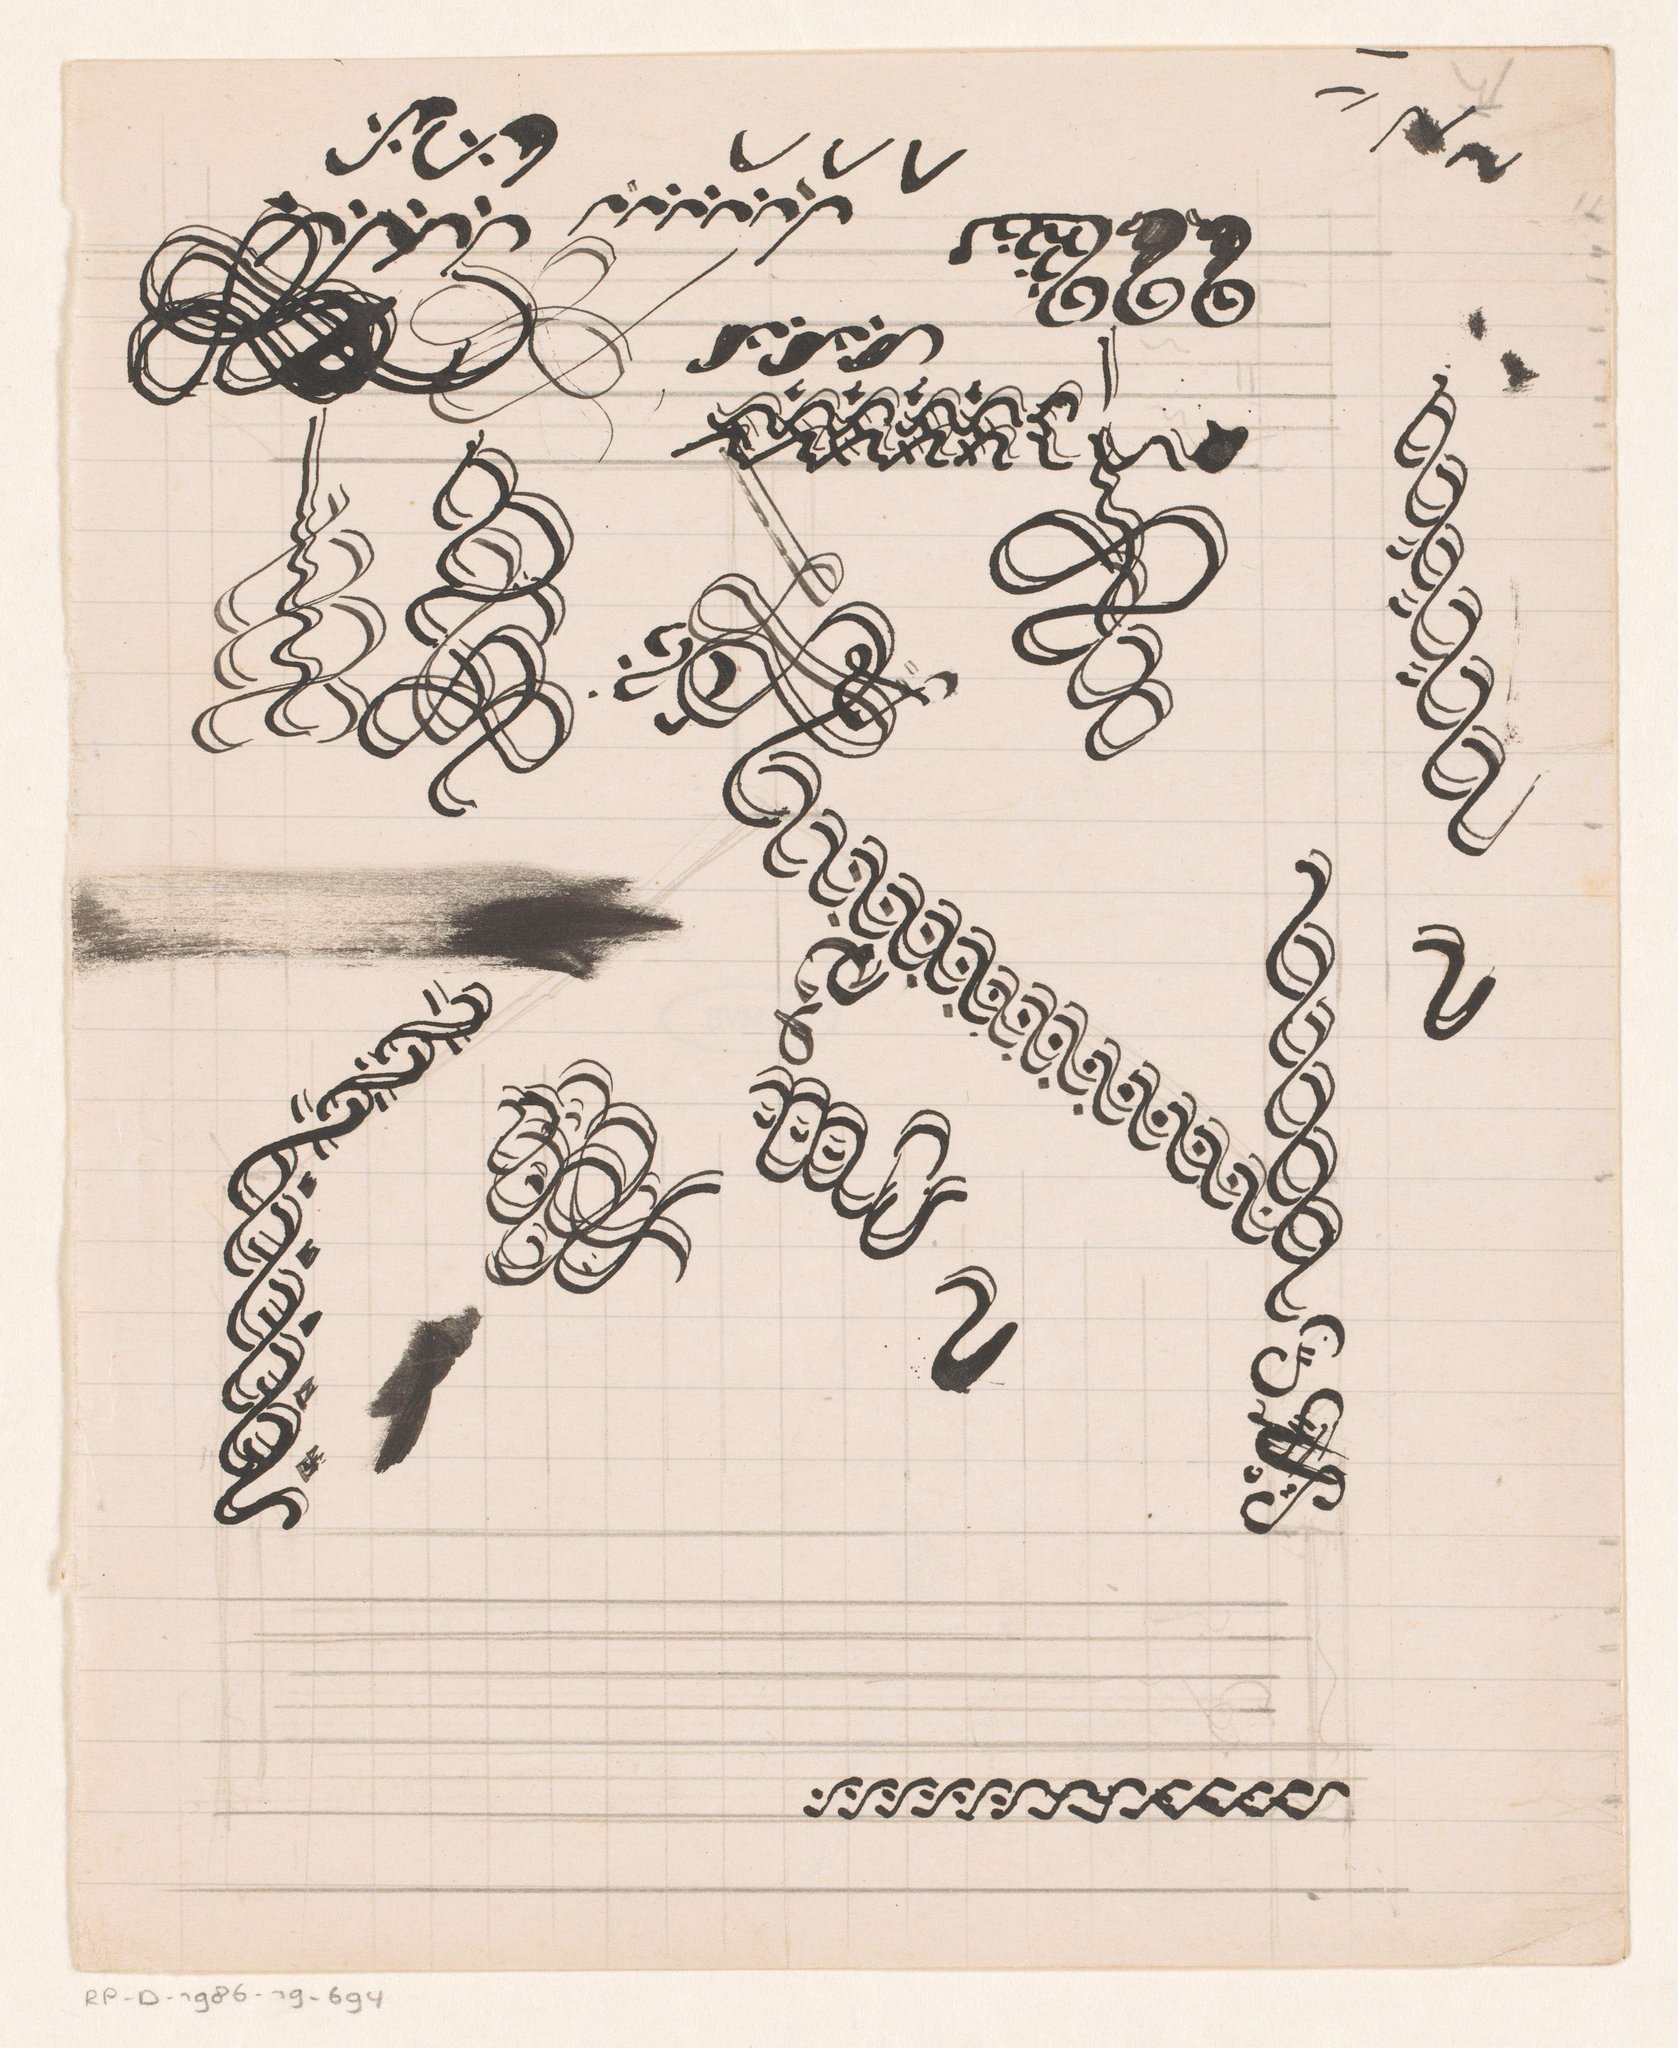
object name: drawing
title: Studieblad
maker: reinier willem petrus de vries (1874-1953)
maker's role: draughtsman, print maker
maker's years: 1874-1953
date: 1884-1952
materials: ink, pencil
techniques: pen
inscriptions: collector's mark: ‘R:MVS.’